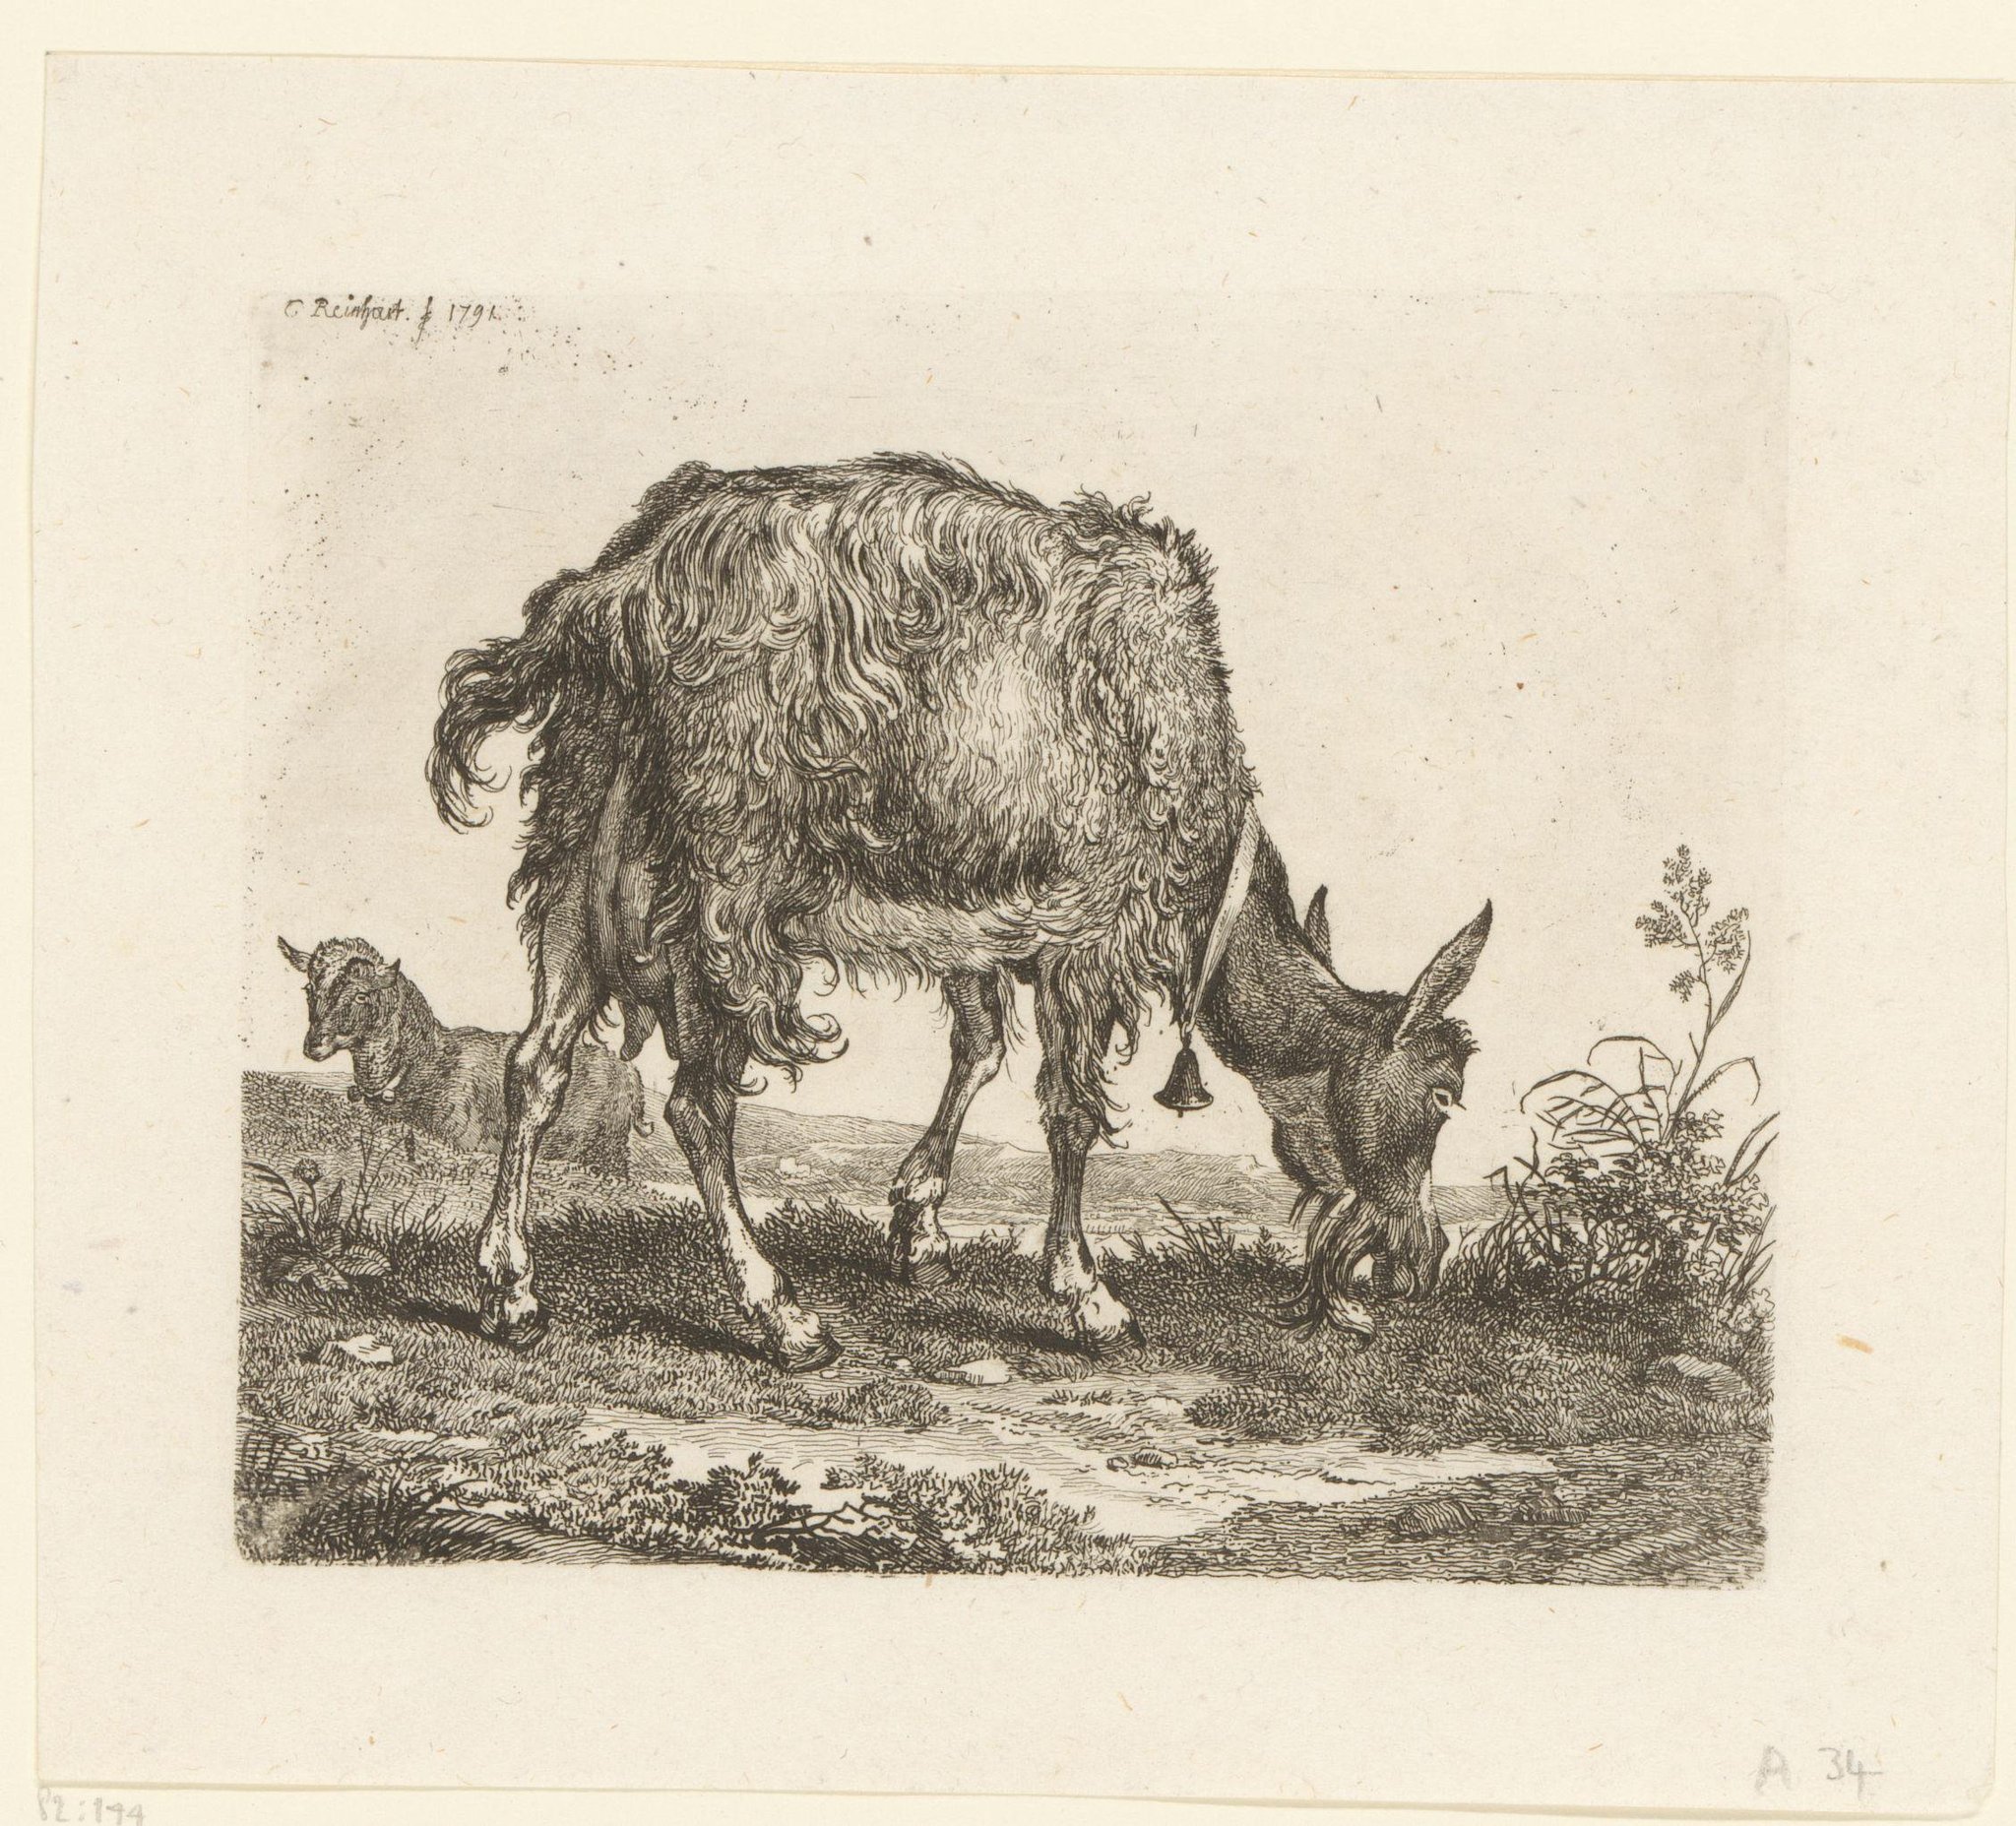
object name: print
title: Dieren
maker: johann christian reinhart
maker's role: print maker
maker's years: 1761-1847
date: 1791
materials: paper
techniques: etching, intaglio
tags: landscapes, goat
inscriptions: collector's mark: Lugt 2760, collector's mark: Lugt 2228